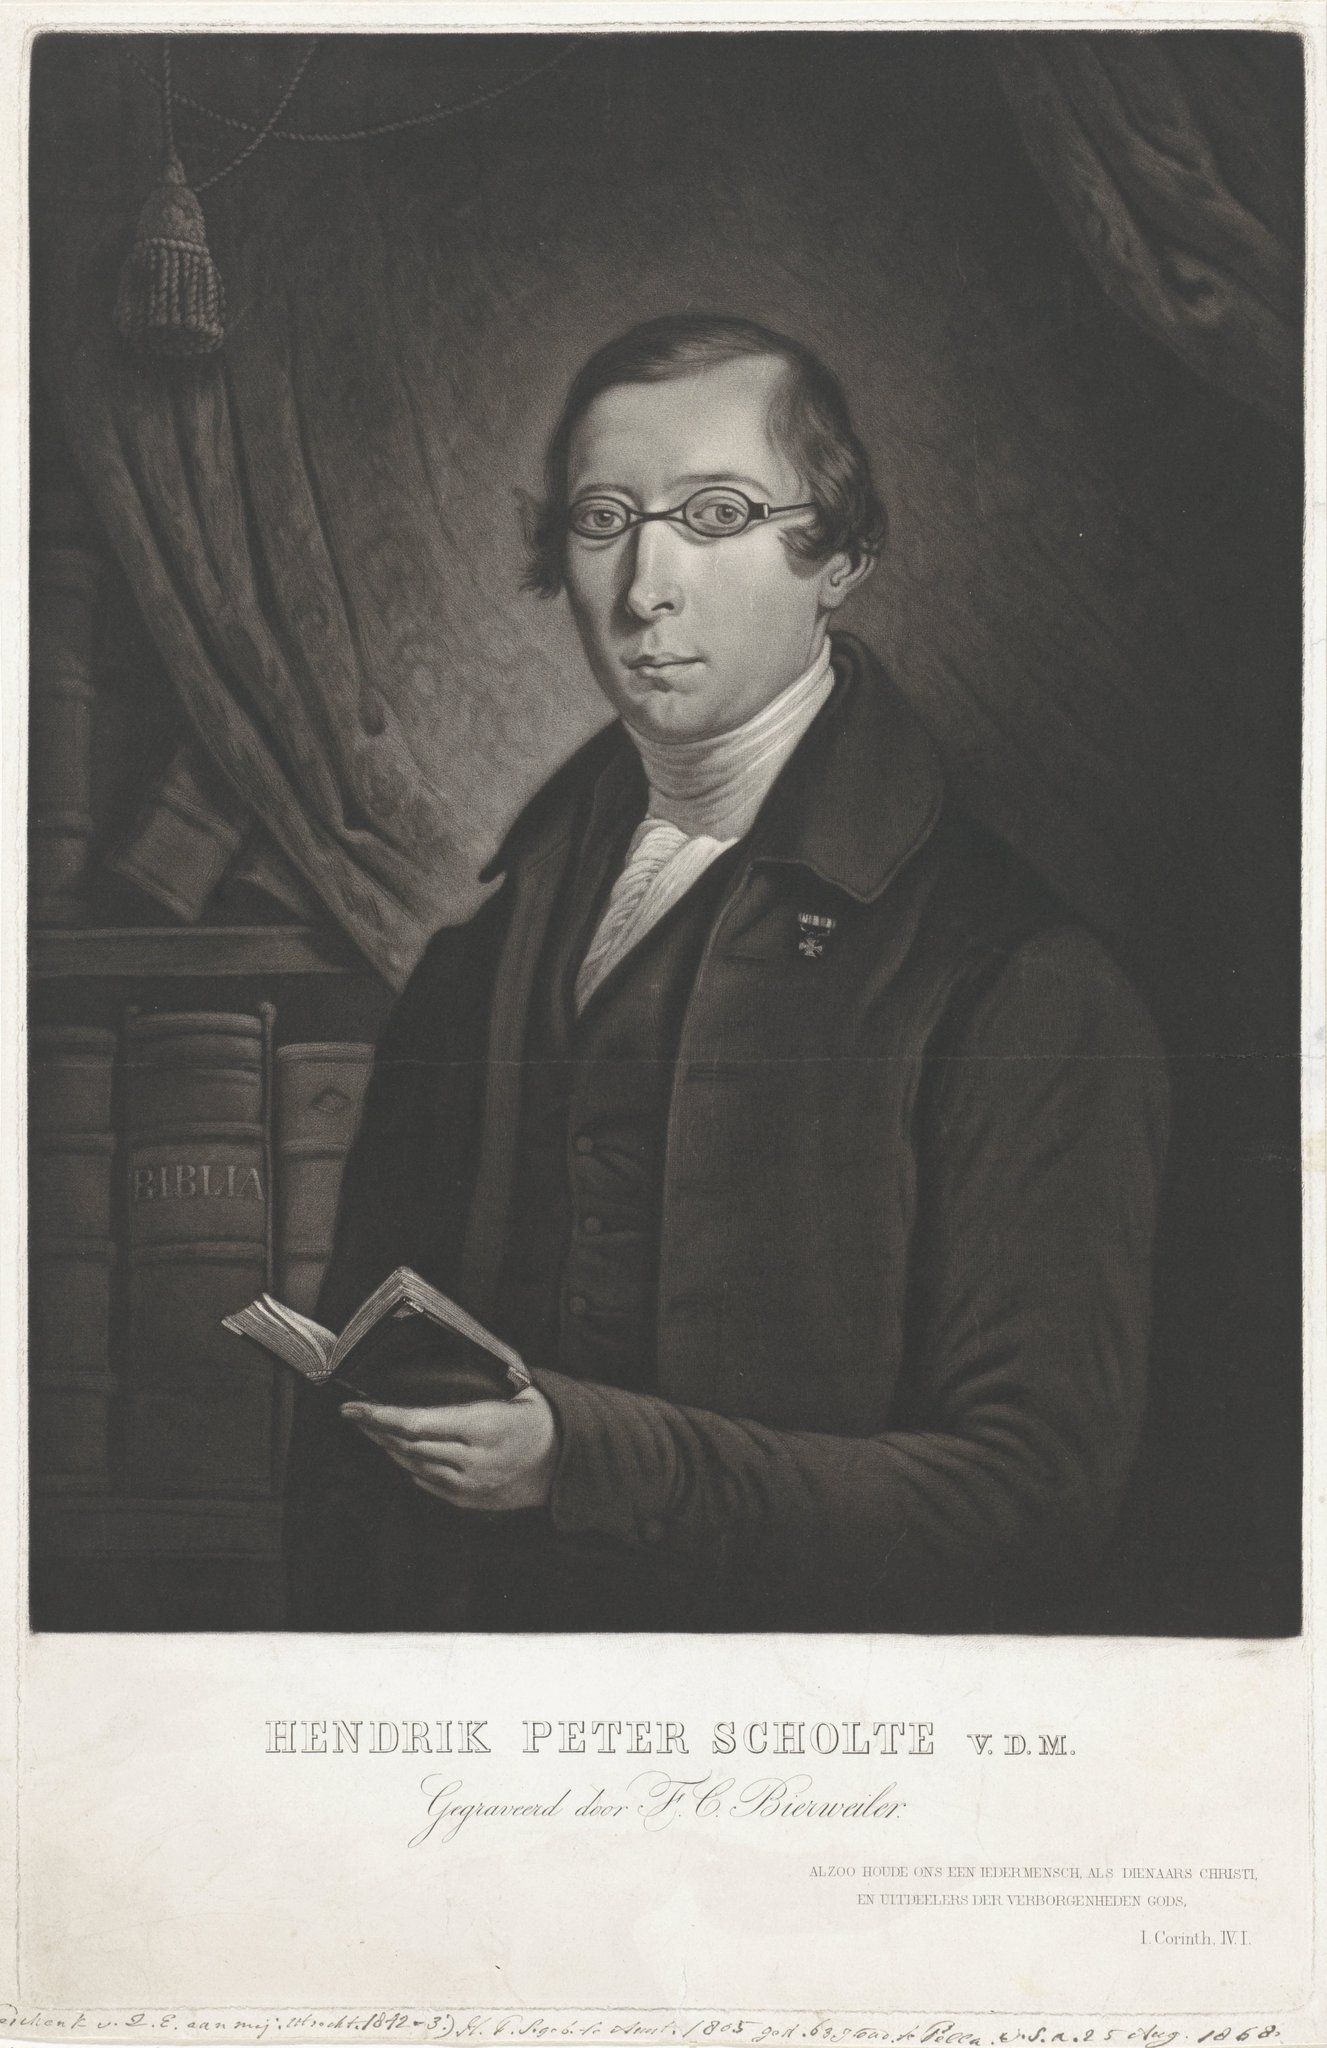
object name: print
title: Portret van de predikant Hendrik Peter Scholte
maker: frederik christiaan bierweiler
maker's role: print maker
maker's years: 1783-1831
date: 1827-1842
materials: paper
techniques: engraving, etching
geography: netherlands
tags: amsterdam, eyeglasses, spectacles, bible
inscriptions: collector's mark: Lugt 2228